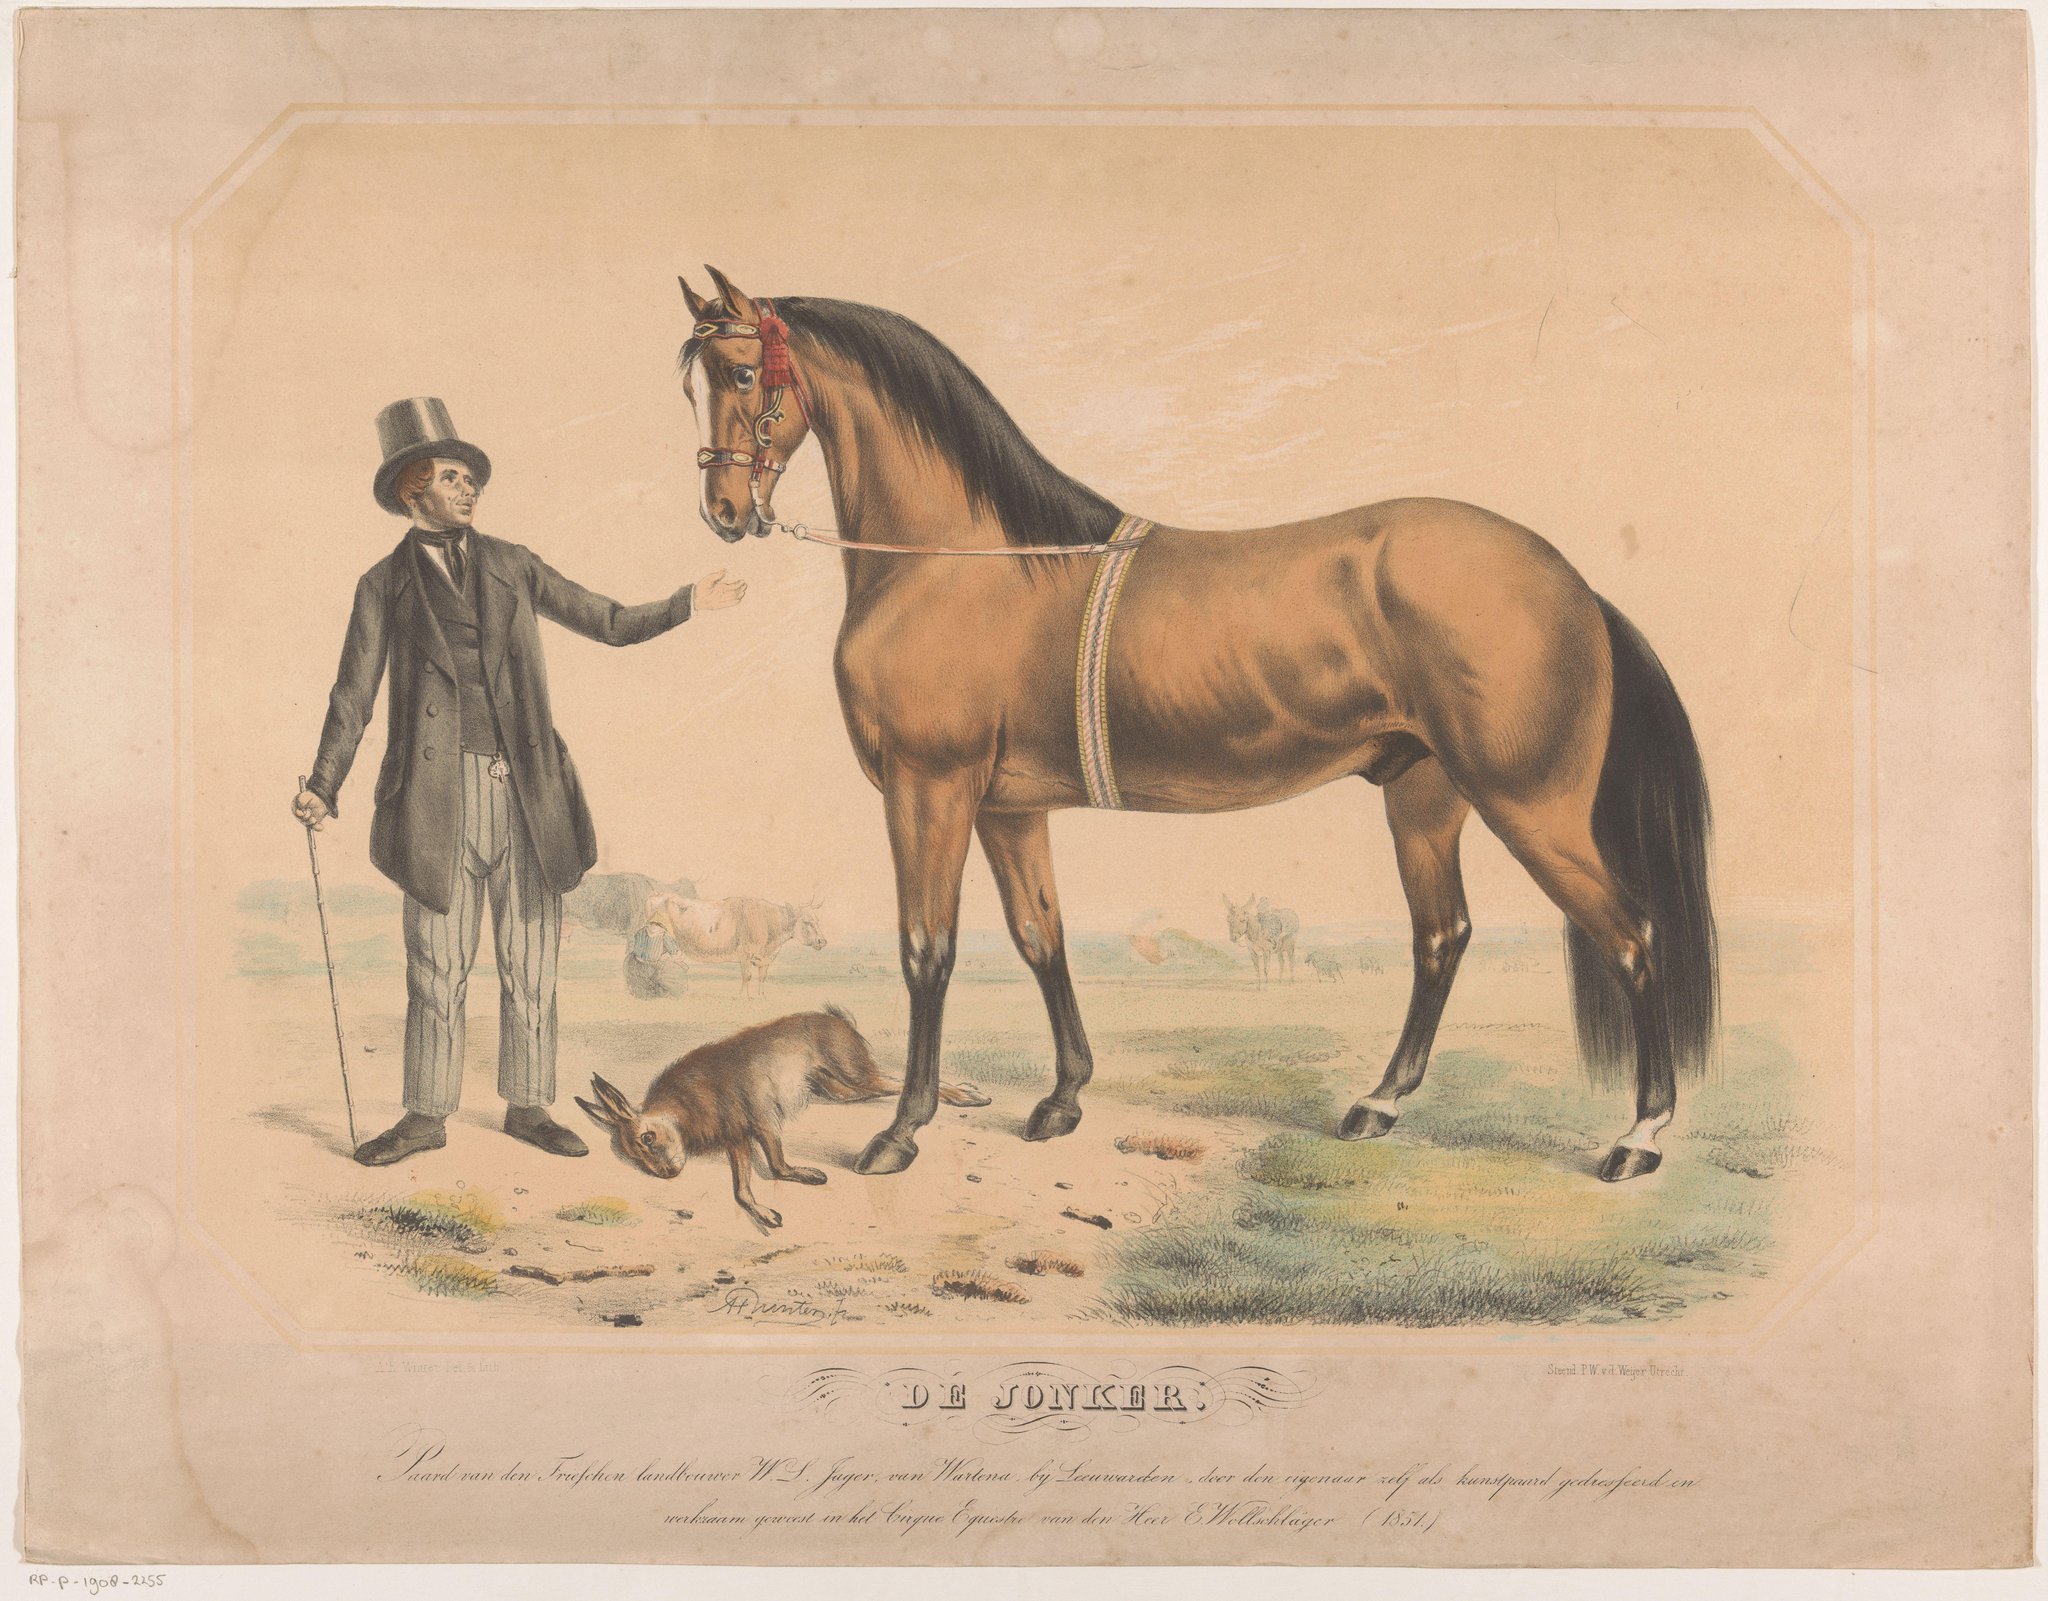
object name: print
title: De Jonker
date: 1851-1861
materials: paper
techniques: hand coloring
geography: utrecht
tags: rodents: hare, horses (circus performance), horse, head-gear: top hat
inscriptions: collector's mark: Lugt 2228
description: Naast het paard staat een man met hoge hoed. Voor het paard ligt een dode haas, mogelijk een verwijzing naar de naam van de eigenaar. Aan de horizon wordt een koe gemolken, rechts staat een bepakte ezel. Volgens de onderstaande tekst trad het paard op in het cirque equestre van de heer Wollschläger.